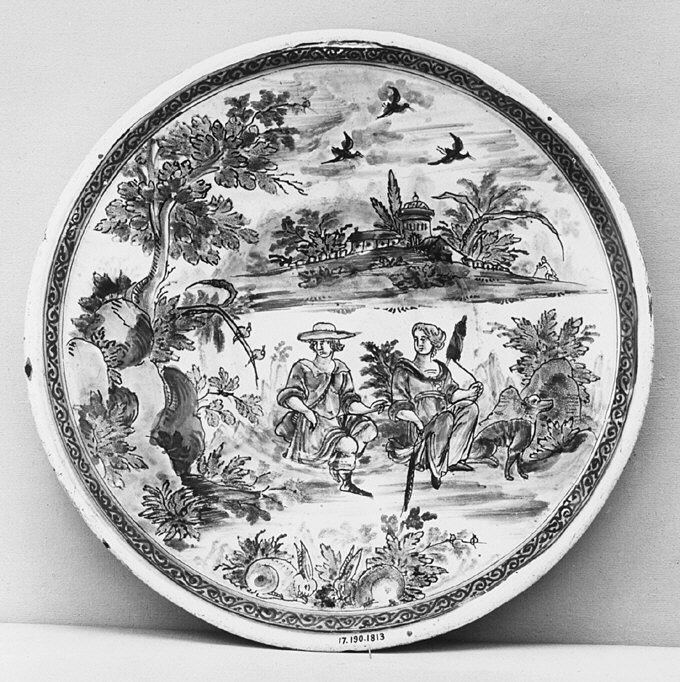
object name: plate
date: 1650-1680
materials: faience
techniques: glazing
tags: birds,women,dogs,rabbits,pastoral,trees